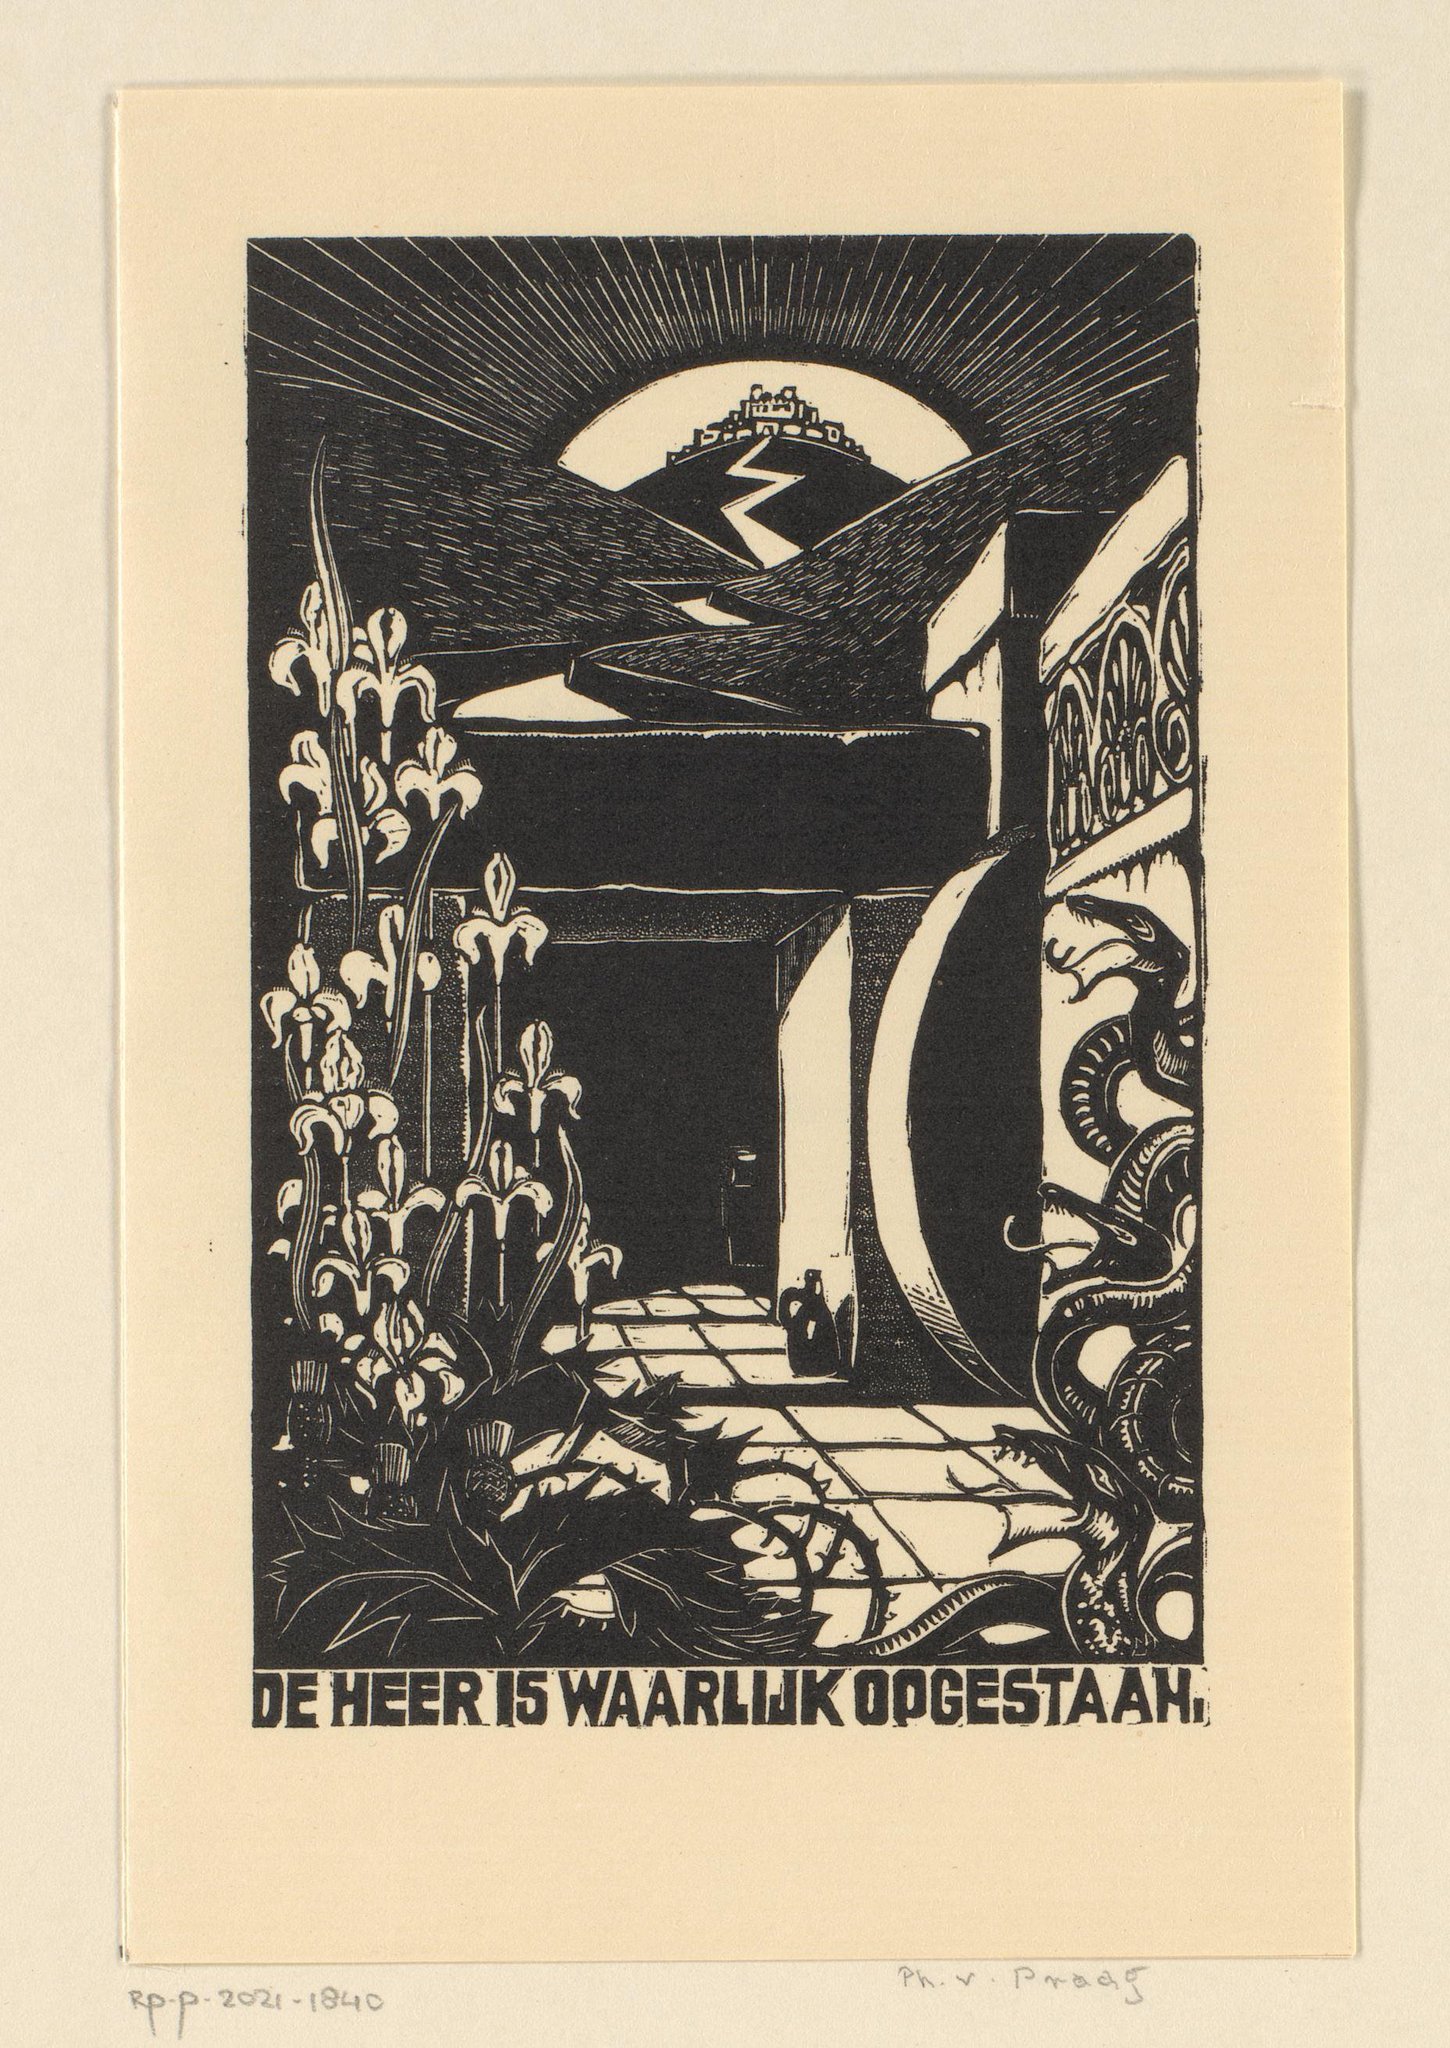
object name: easter card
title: Paaskaart van Bernard W.M. Ottevanger voor 1934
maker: philip van praag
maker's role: draughtsman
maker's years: 1887-1942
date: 1934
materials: paper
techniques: linocut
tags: snakes, flowers: lily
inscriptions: date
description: Paaskaart met een stad op een heuvel waarachter de zon opgaat. Op de voorgrond rechts slangen en links lelies. Met de tekst 'De Heer is waarlijk opgestaan'.